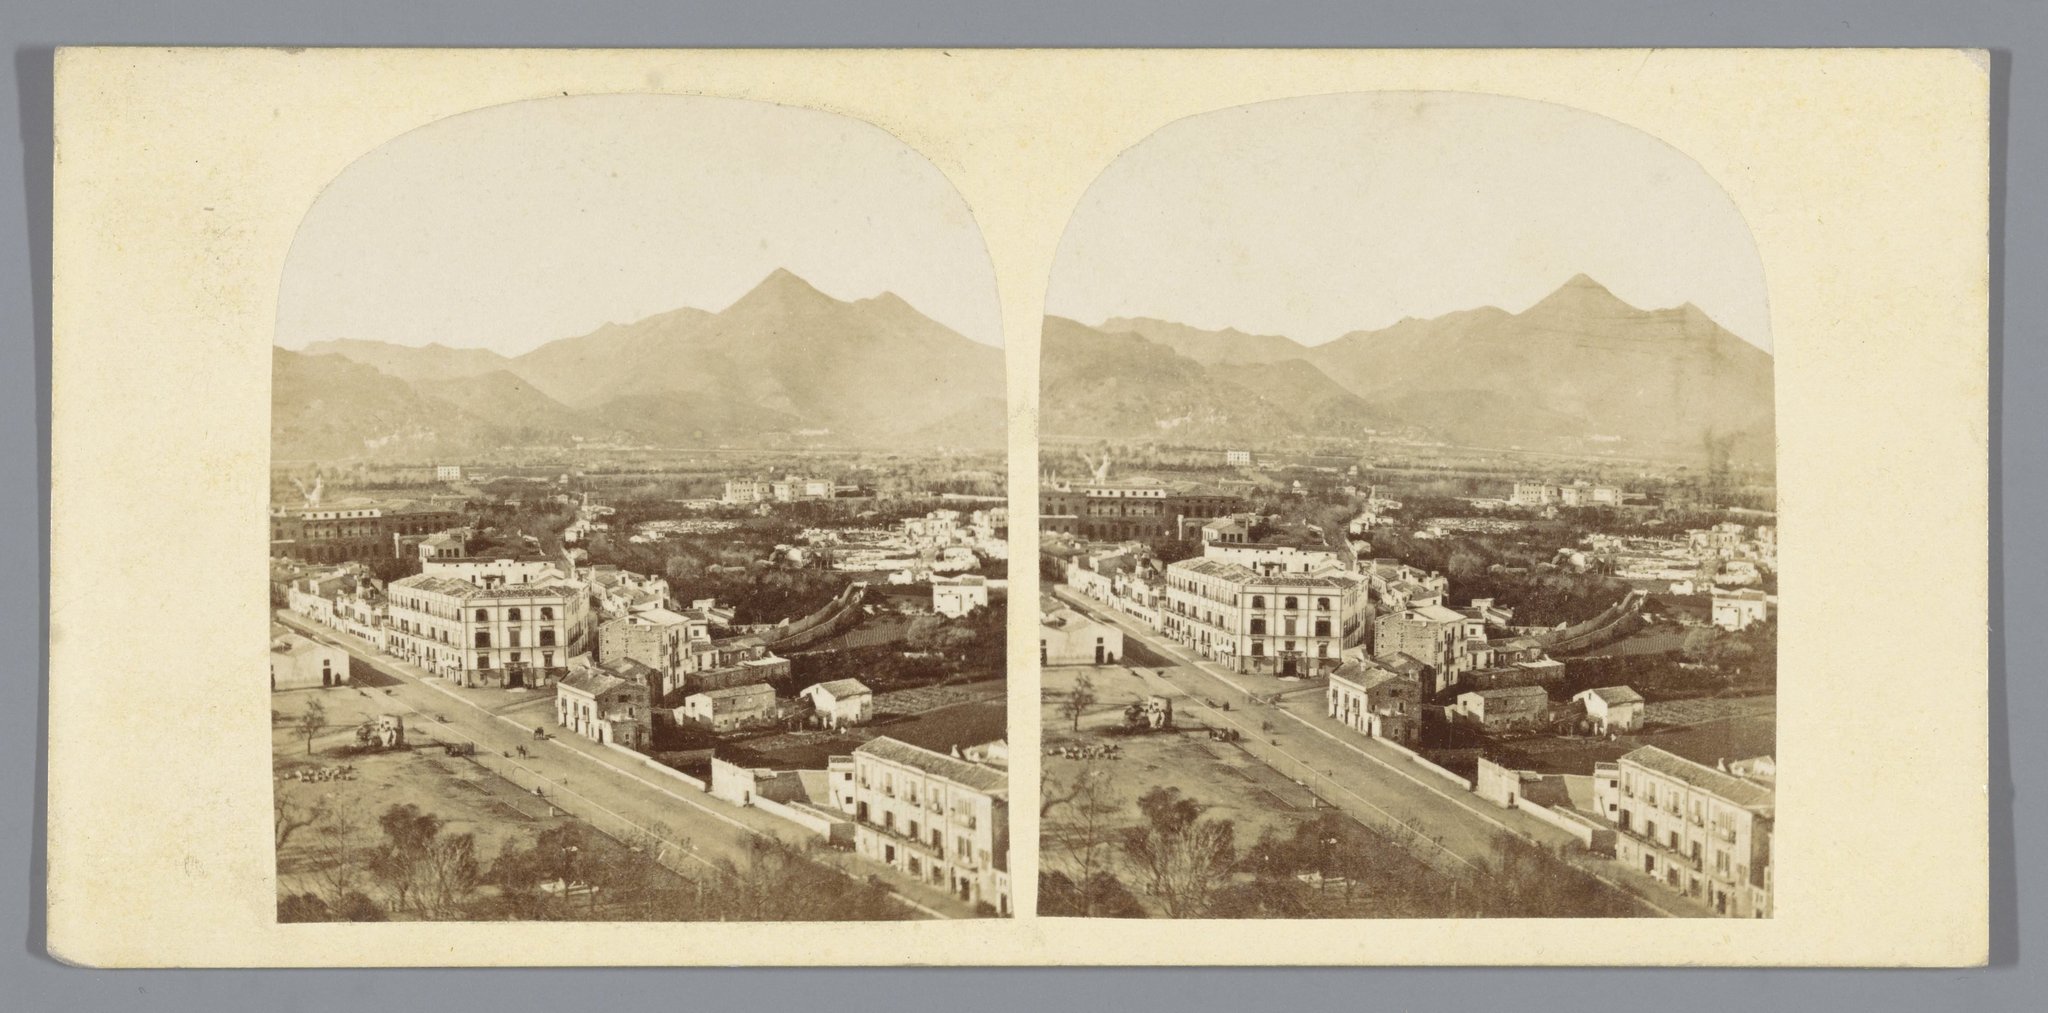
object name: stereograph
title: Gezicht op de omgeving van Palermo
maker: Anonymous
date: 1850-1880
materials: cardboard, photographic support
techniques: albumen print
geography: palermo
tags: outskirts of city, mountains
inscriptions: inscription: ‘Panorama des environs de Palermes’